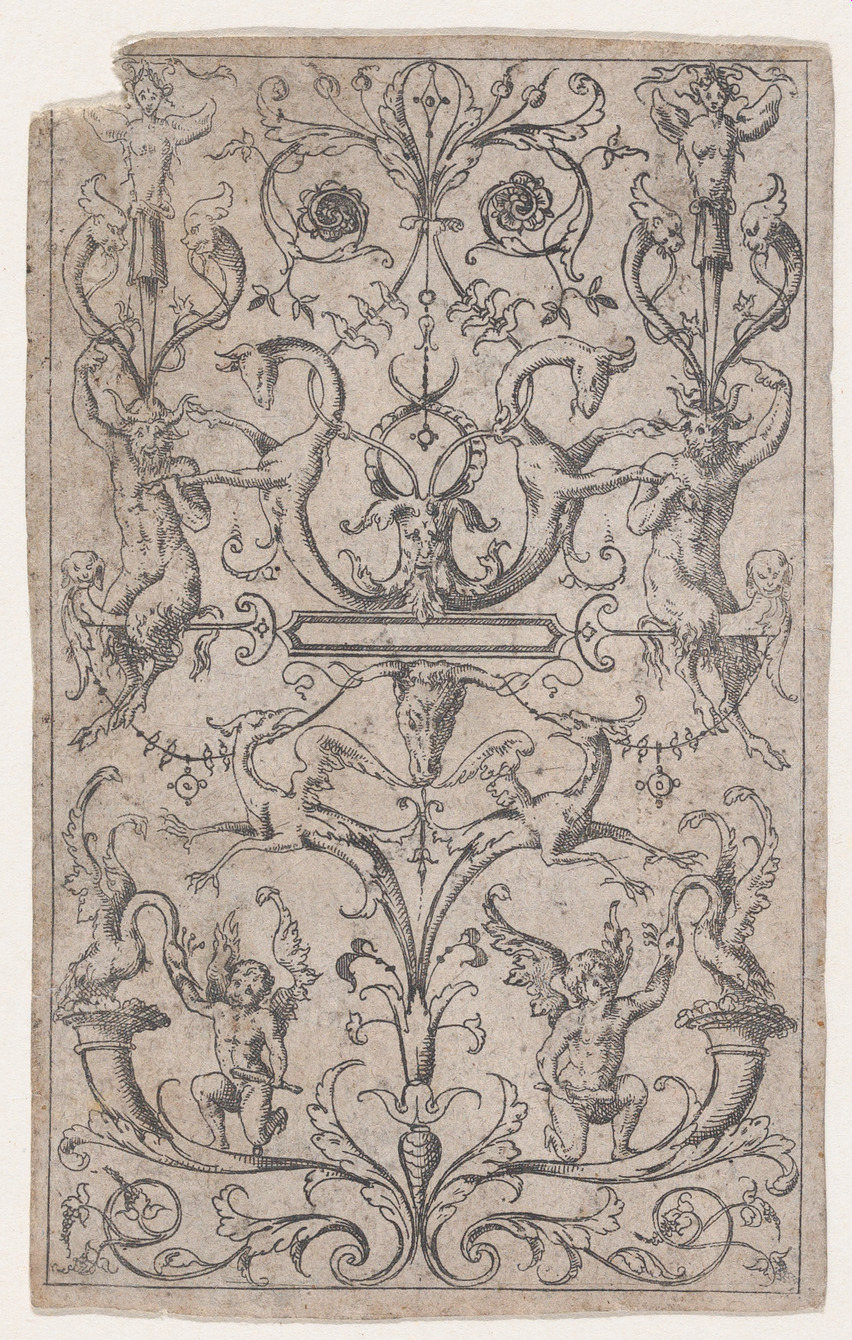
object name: print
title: Panel of Grotesques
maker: jacques androuet du cerceau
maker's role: artist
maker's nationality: french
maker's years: 1510-1585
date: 1530-1585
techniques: etching